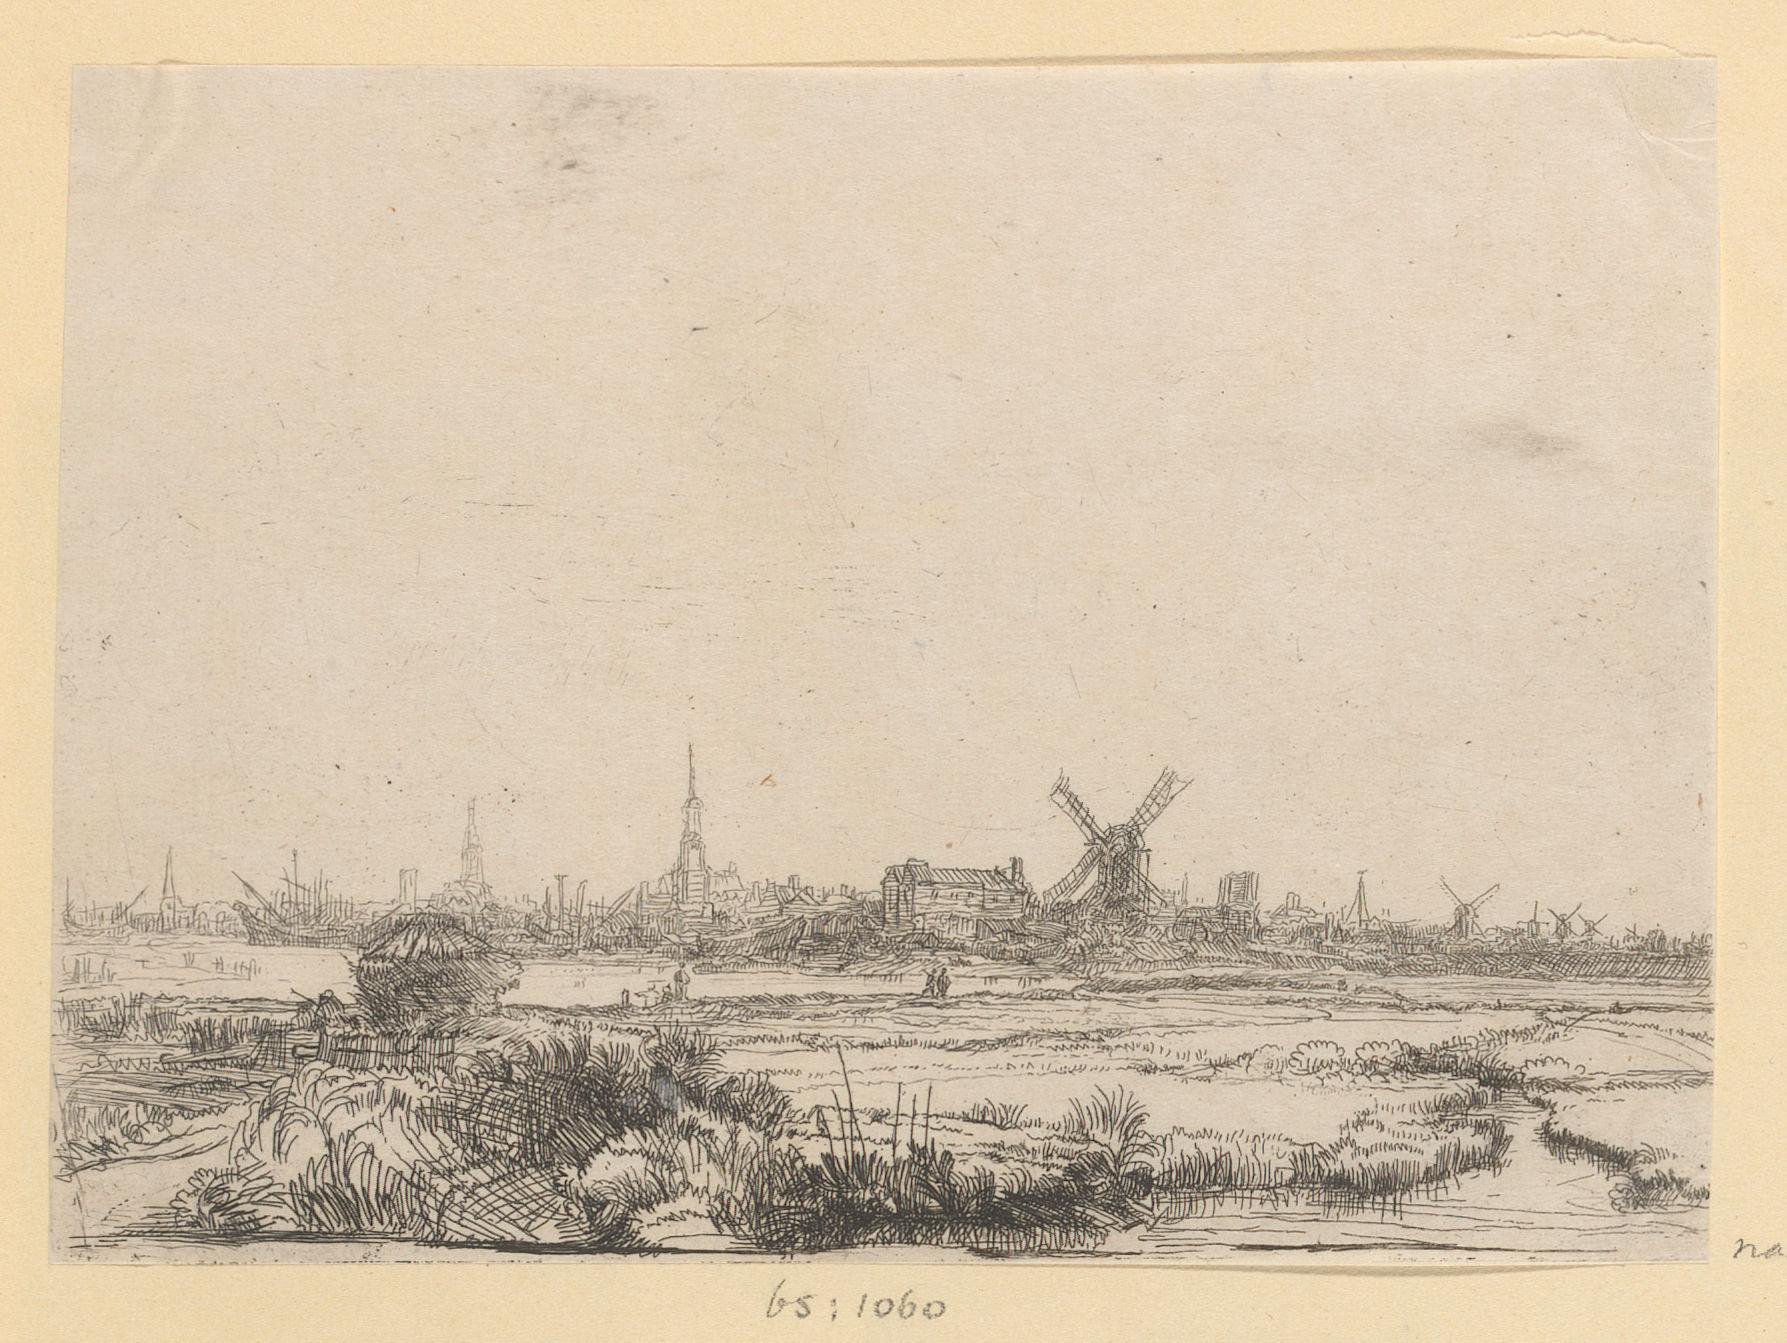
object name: album leaf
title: Gezicht op Amsterdam uit het noordwesten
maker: Anonymous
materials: paper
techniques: etching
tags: city-view in general; 'veduta' (+ city(-scape) with figures, staffage), amsterdam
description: Prent maakt mogelijk deel uit van een serie van 200 prenten. Deze serie is onder de titel 'A Collection of two hundred original etchings' voor het eerst uitgegeven door J.M. Greery in 1816.